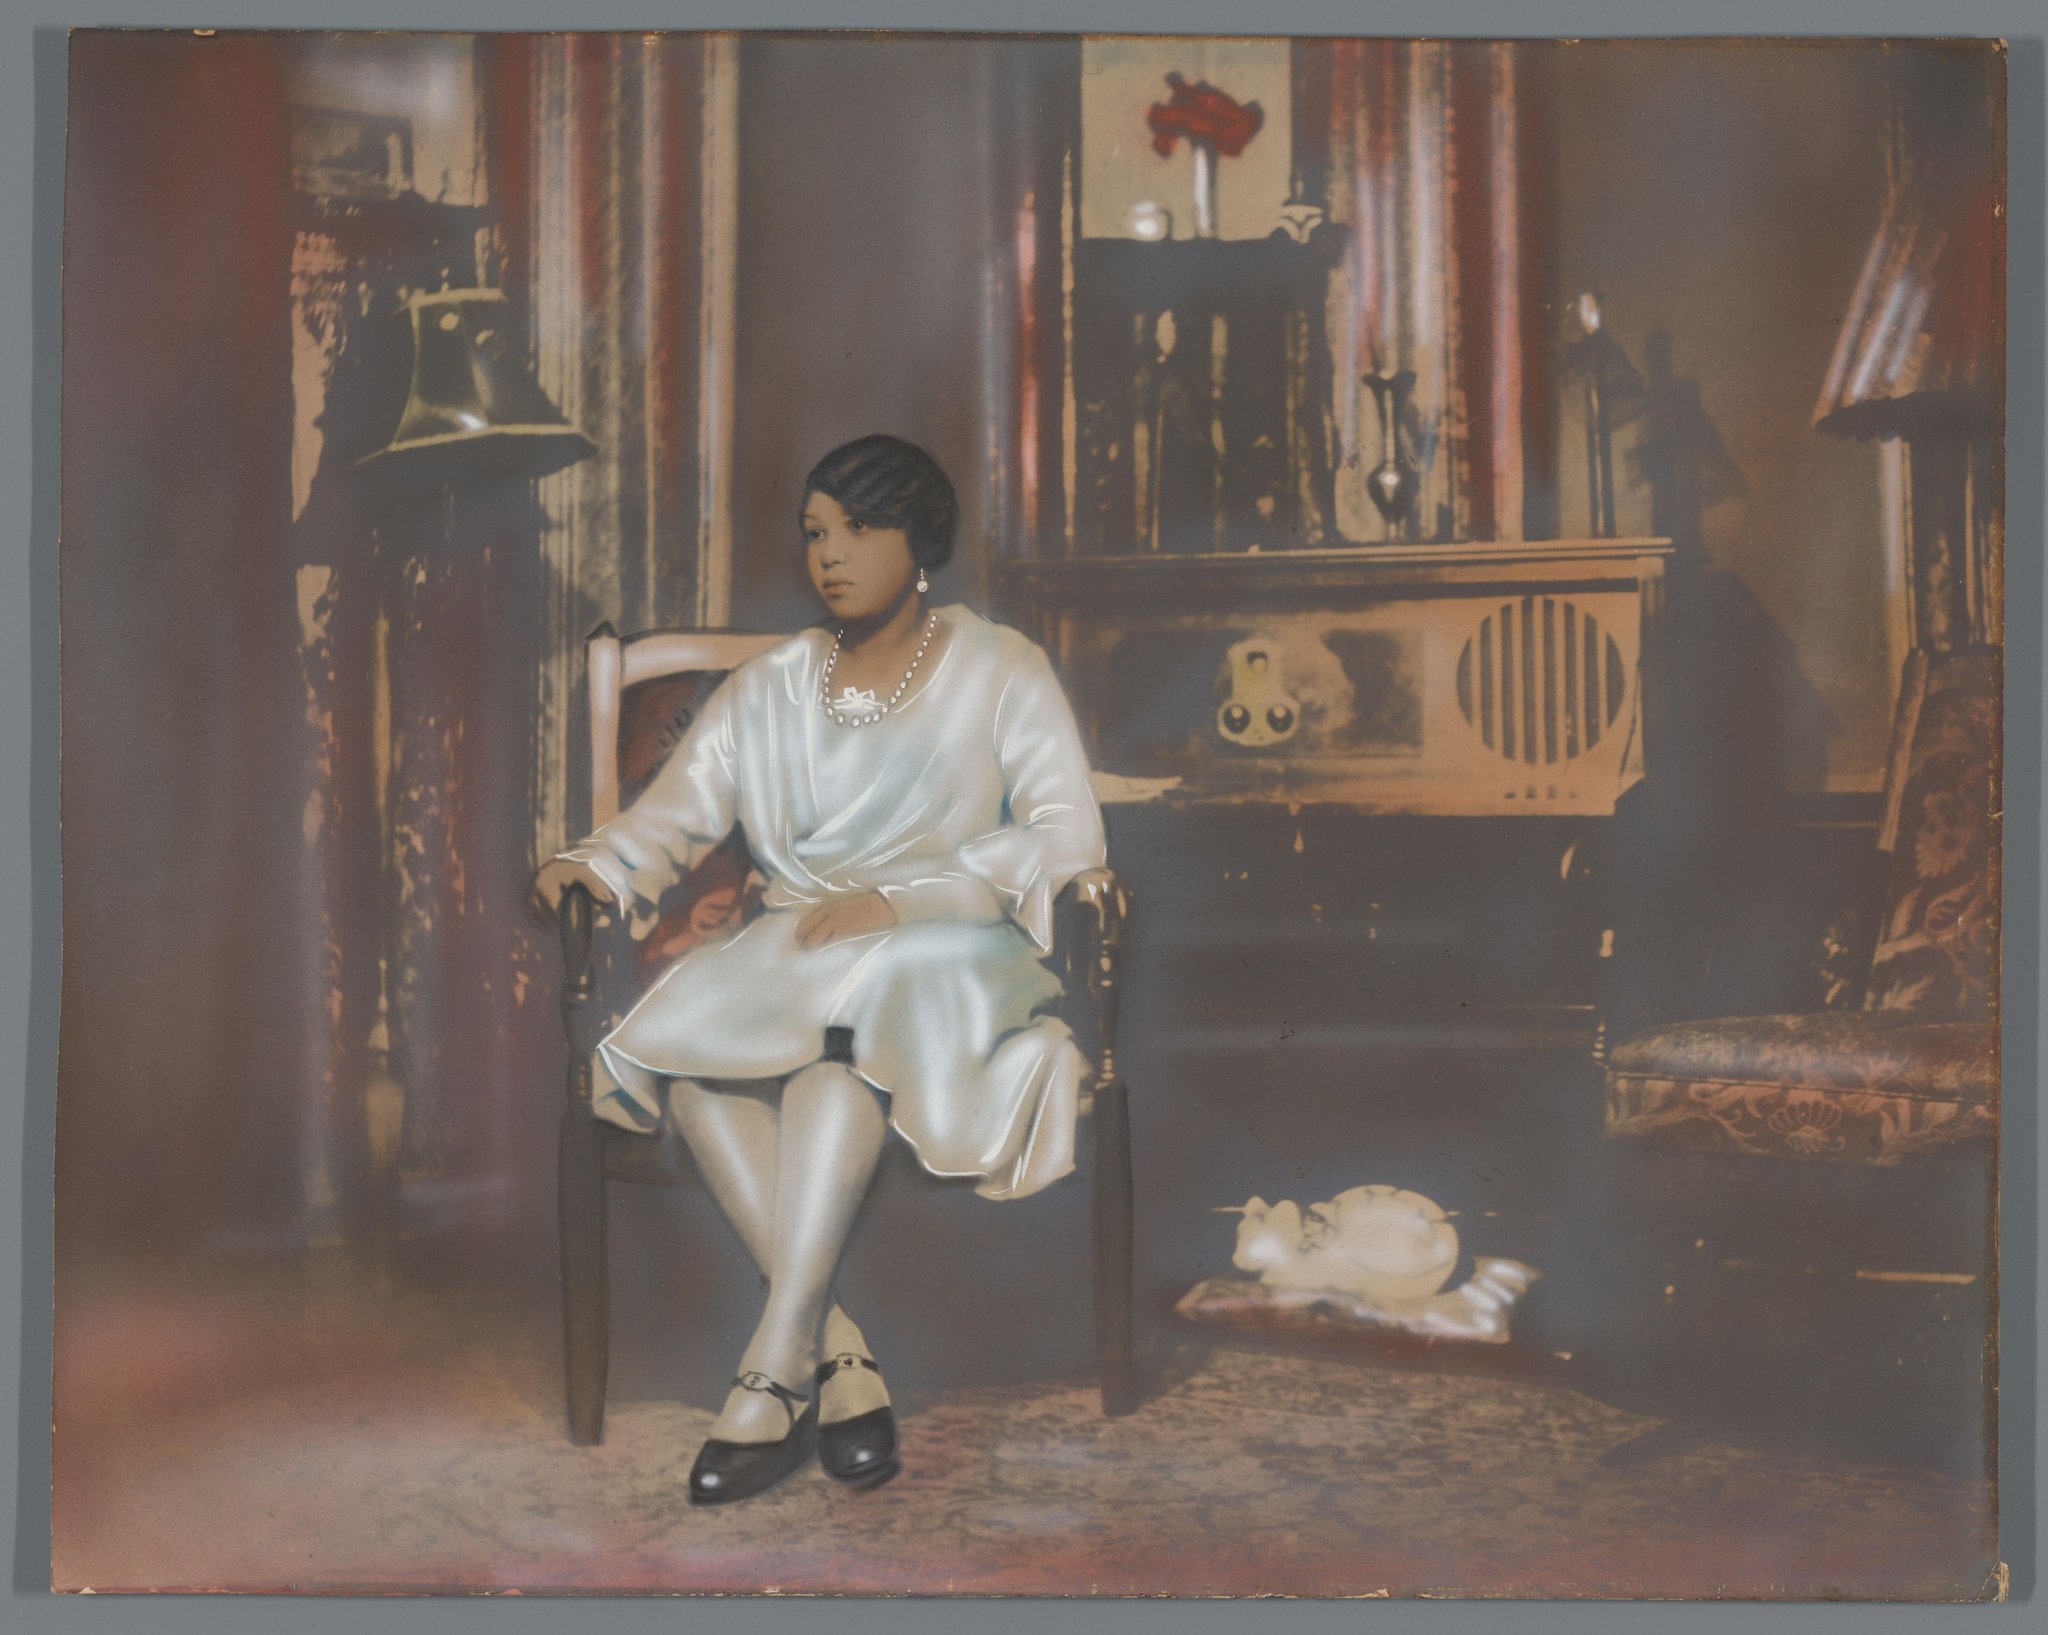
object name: frame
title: Portret (ingekleurd) van een Zwarte vrouw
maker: Anonymous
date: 1920-1929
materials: paper, cardboard, coal, gouache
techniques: gelatin silver print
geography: united states